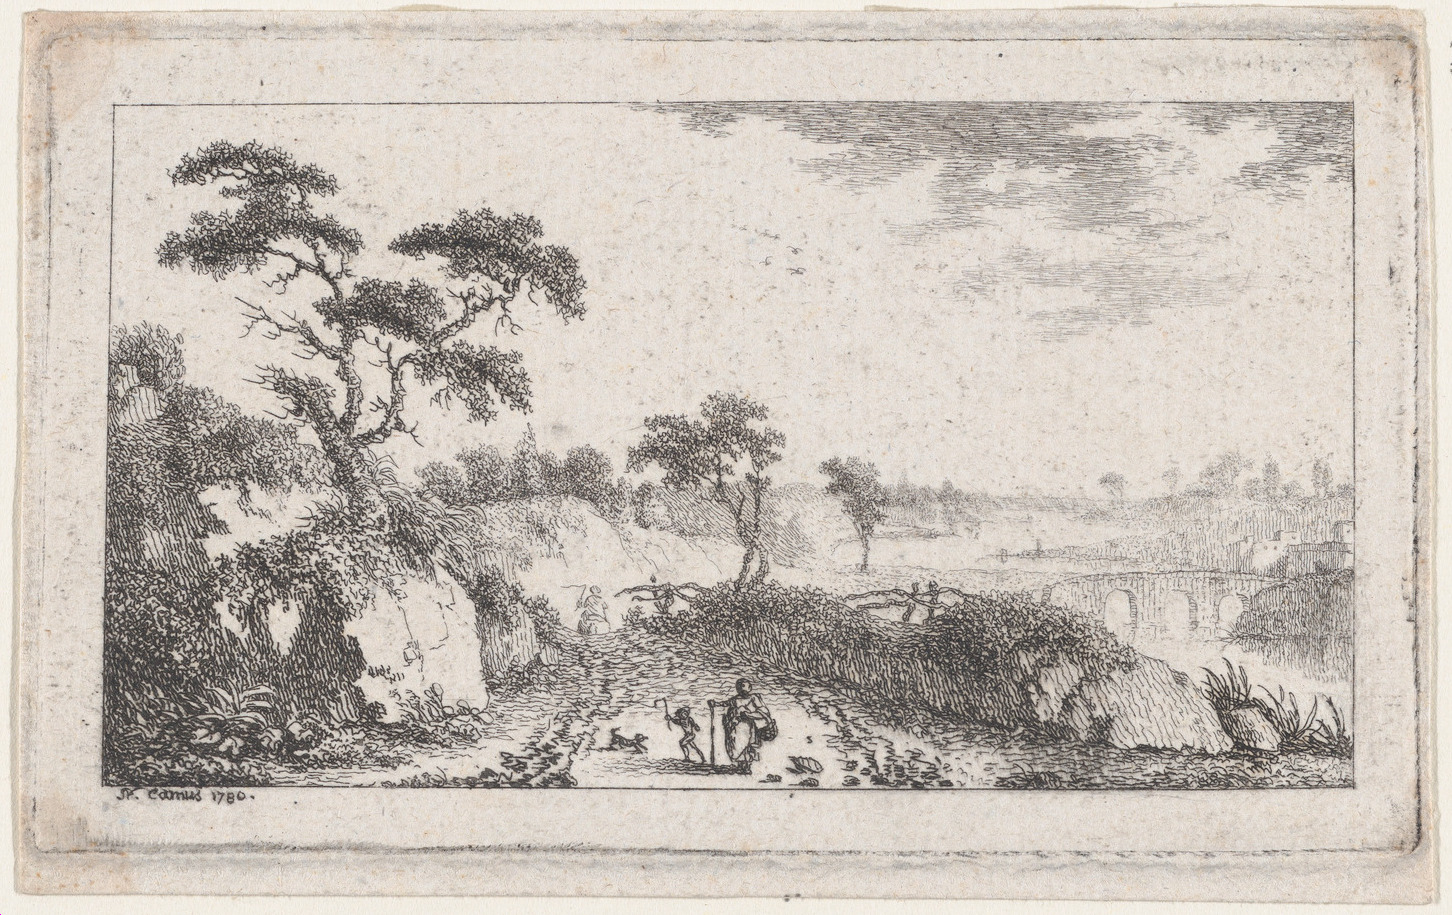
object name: print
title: Landscape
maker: pierre nicholas camus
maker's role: artist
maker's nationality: french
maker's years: 1779-1780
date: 1780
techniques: etching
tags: landscapes